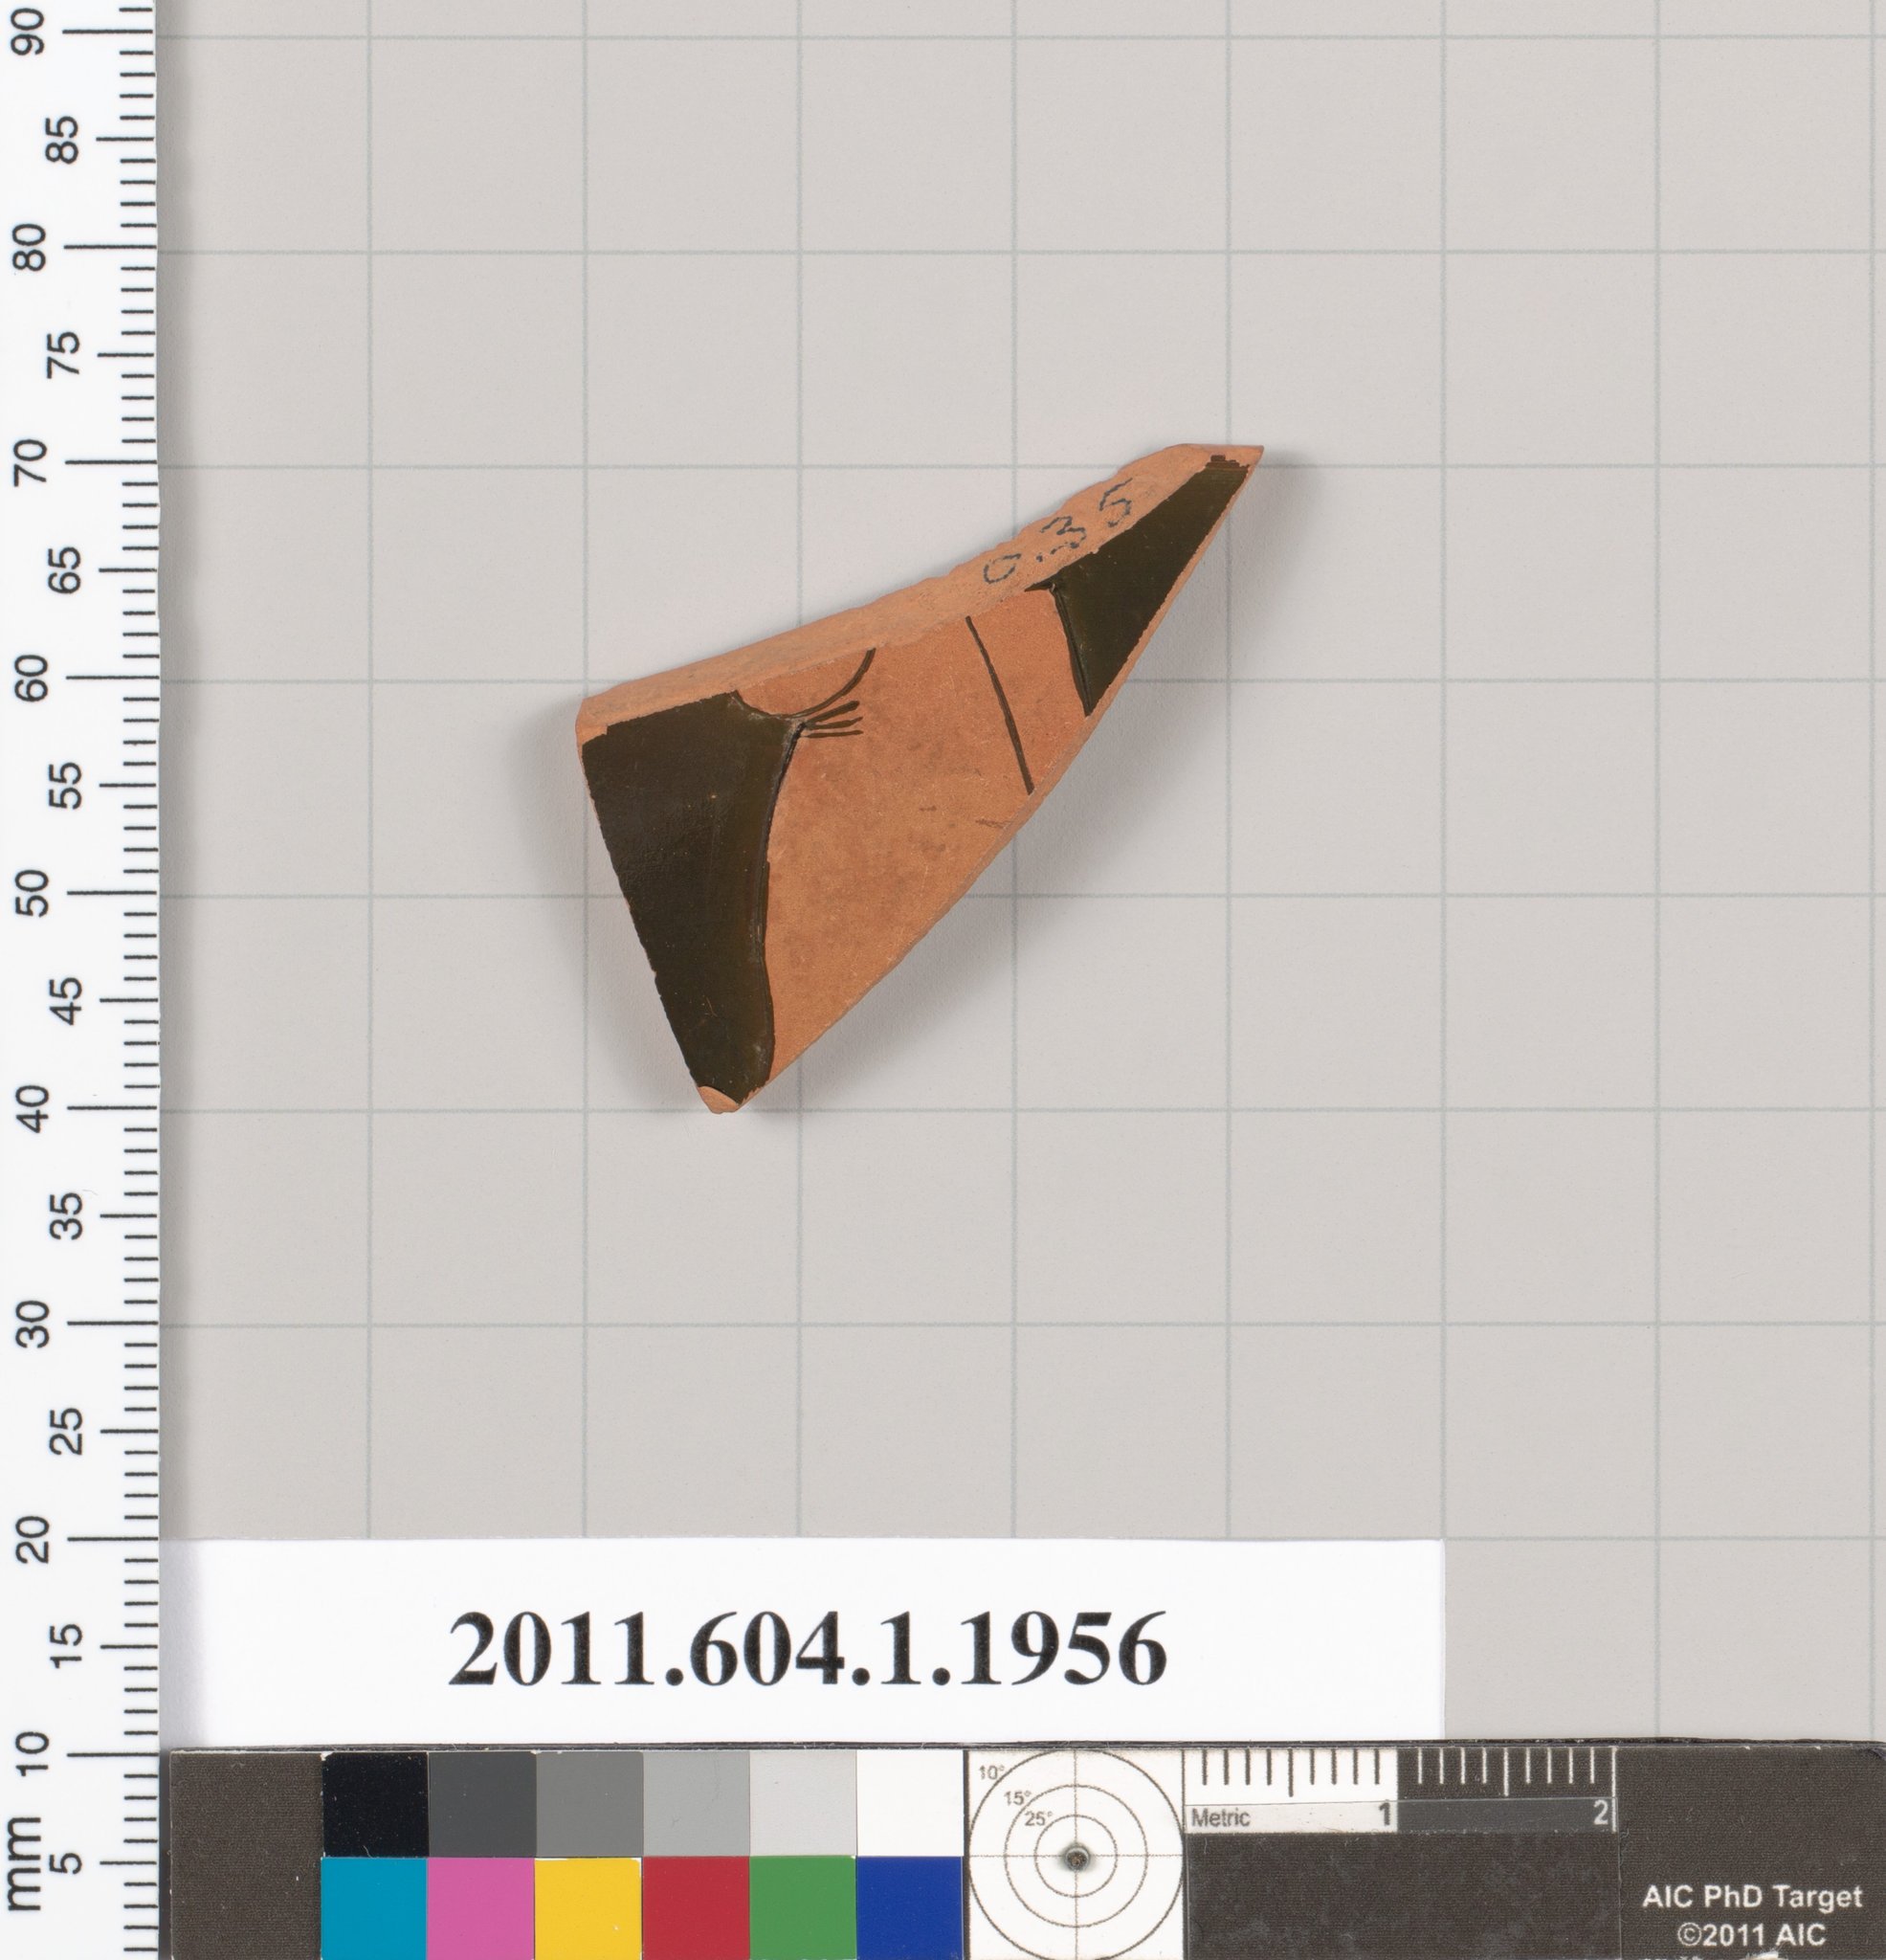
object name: kylix fragment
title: Terracotta rim fragment of a kylix (drinking cup)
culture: greek, attic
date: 475-451 BCE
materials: terracotta